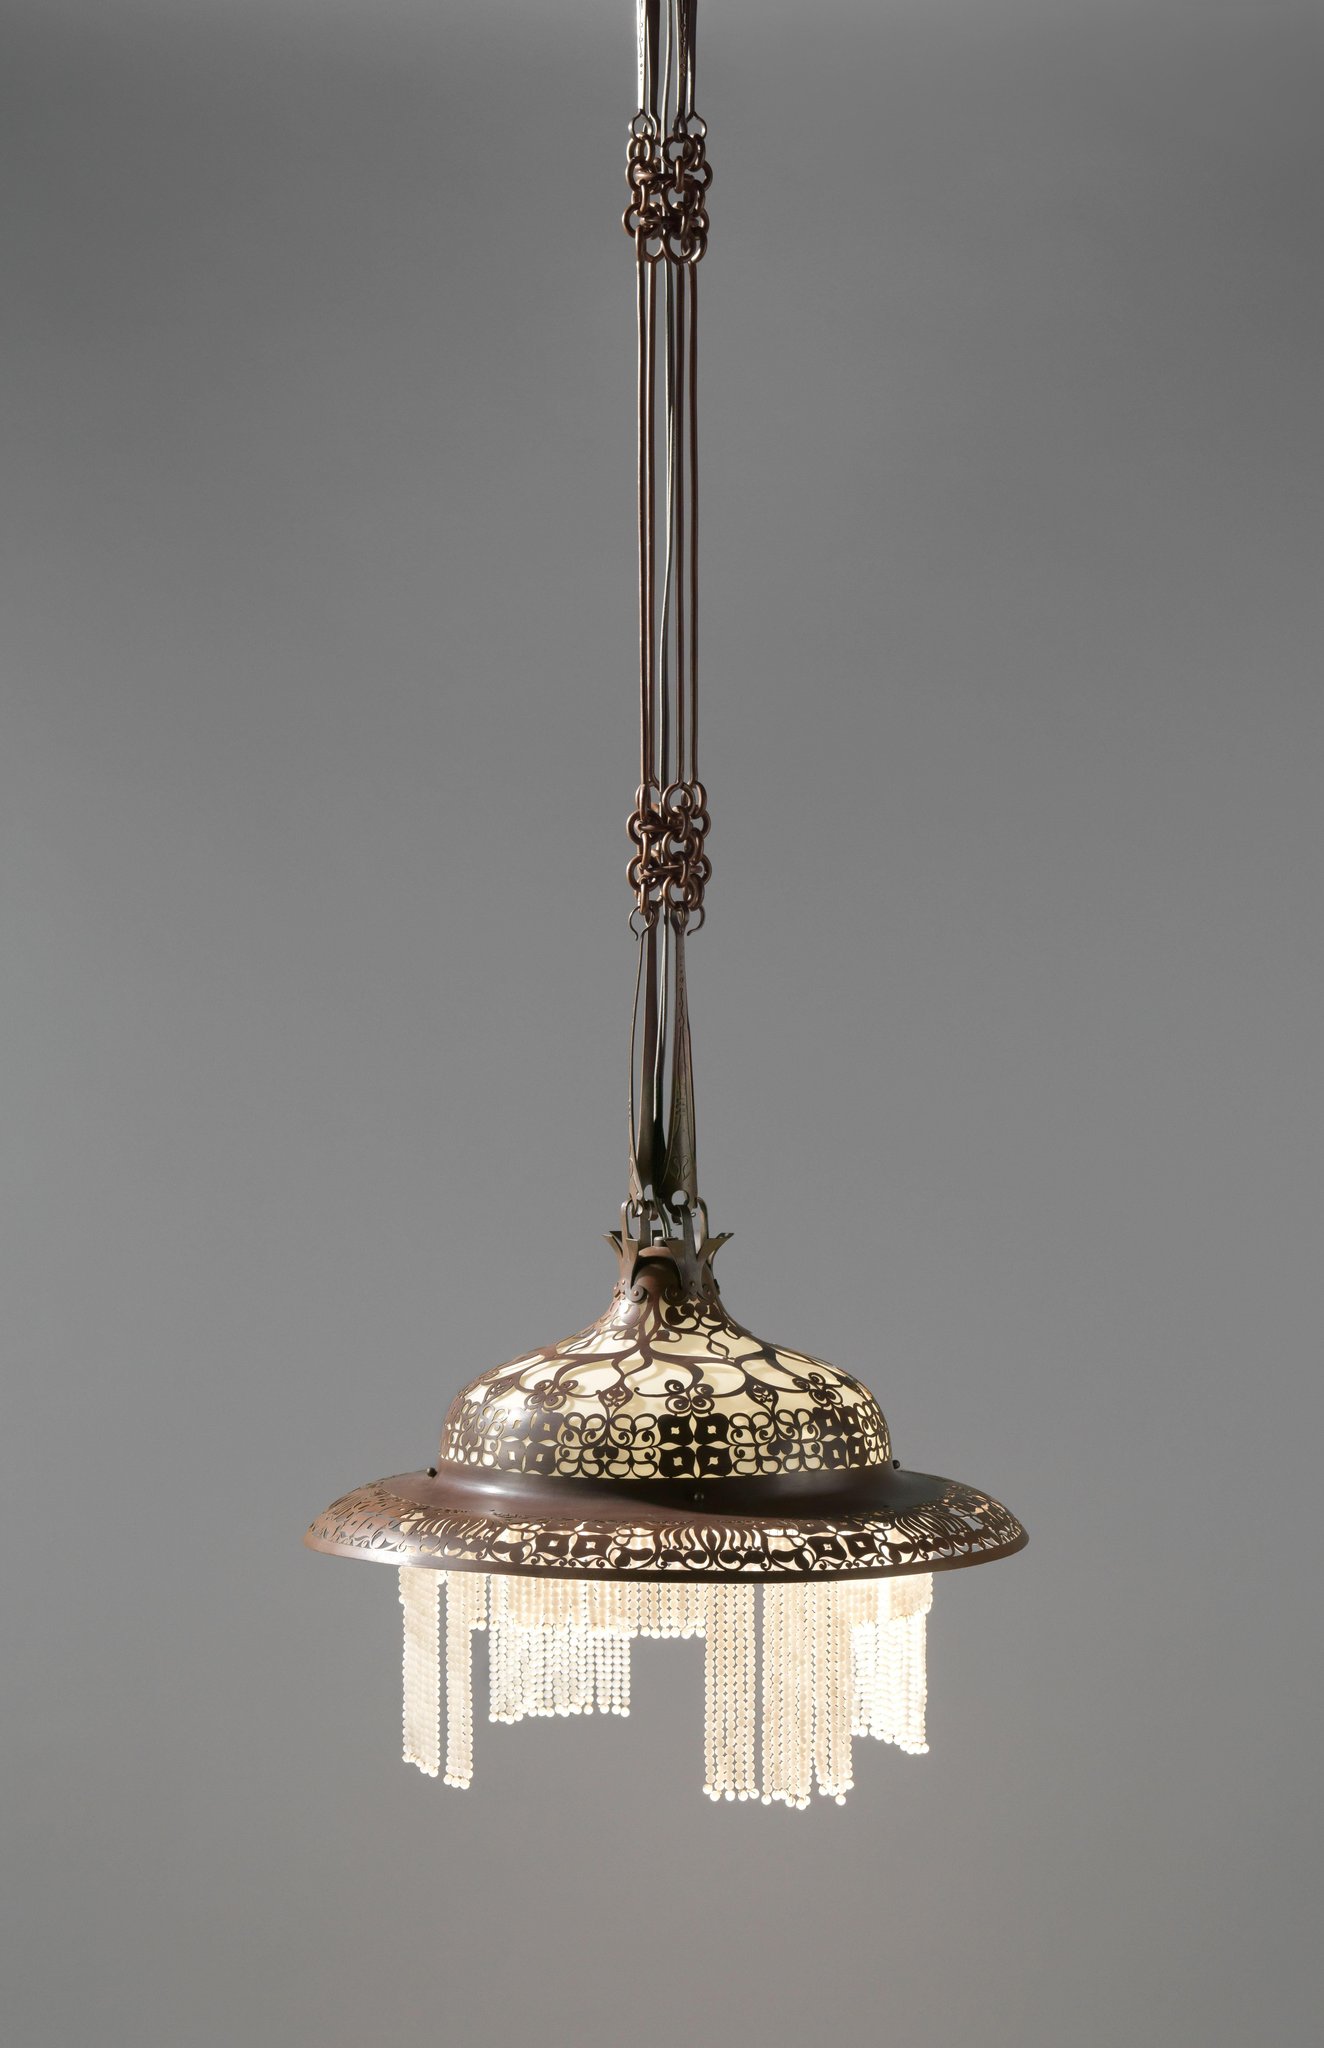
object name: hanging lamp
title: Ketting van een koperen hanglamp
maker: theo nieuwenhuis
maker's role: designer, draughtsman, print maker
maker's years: 1866-1951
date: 1916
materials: copper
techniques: etching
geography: amsterdam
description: Elektrische hanglamp van rood koper bestaande uit een aan vier kettingen gehangen kap die is opengewerkt met ranken en vogelmotieven. Aan de binnenzijde is een bol van matglas. De kettingen bestaan uit drie stangen die op twee plekken onderbroken zijn door schakels. De kap is aan de onderzijde afgezet met een volant van matglazen kralen en afgeschermd met een naturelkleurige gebatikte doek.